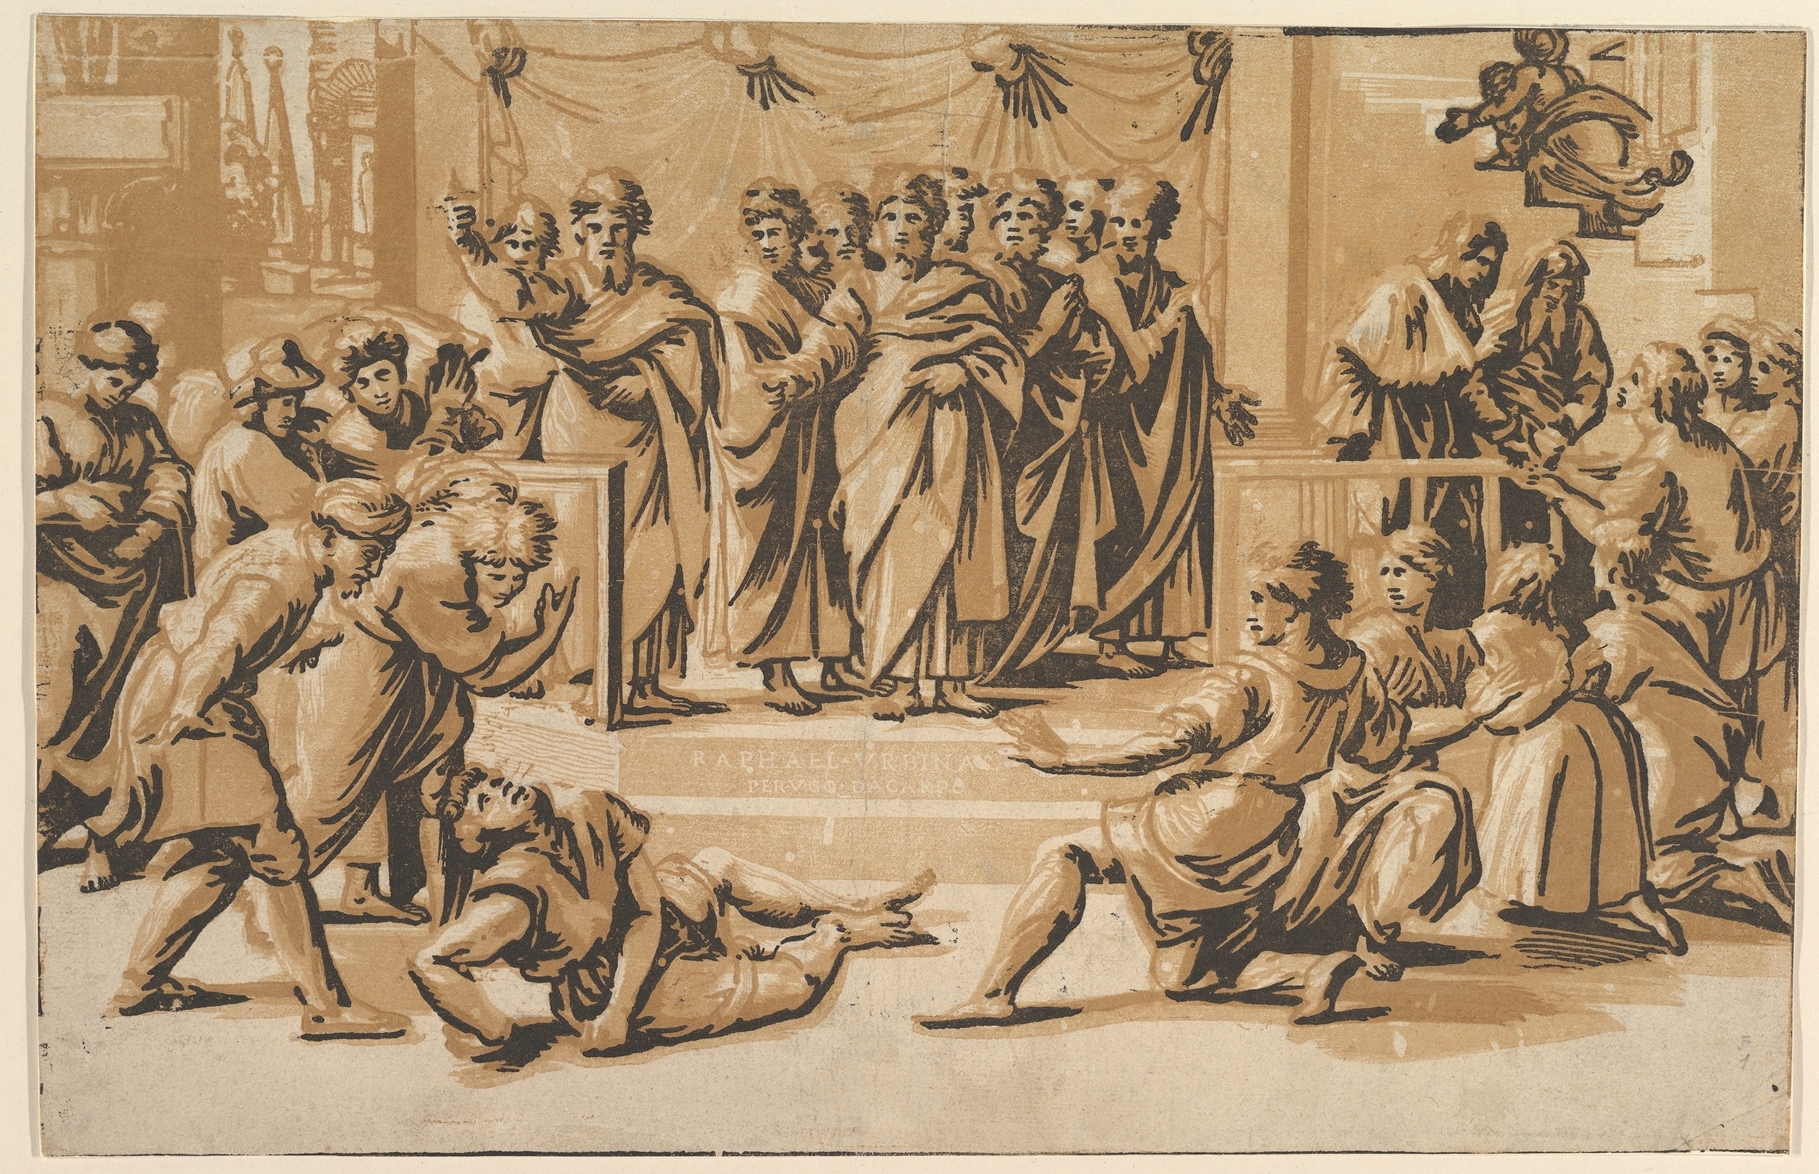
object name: print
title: The death of Ananias, surrounded by Apostles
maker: ugo da carpi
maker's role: artist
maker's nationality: italian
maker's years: 1480-1532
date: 1518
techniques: woodcut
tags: men,apostles,death